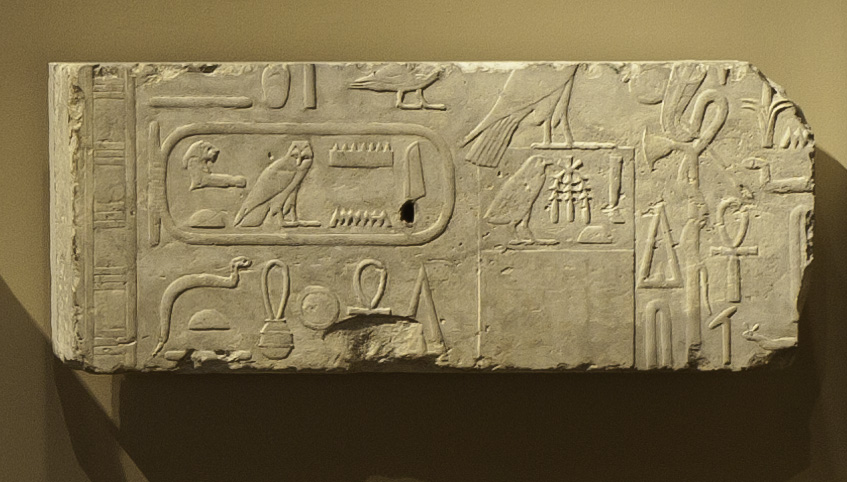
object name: relief, senwosret i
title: Relief block with the names and titles of Amenemhat I and Senwosret I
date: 1962-1952 BCE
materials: limestone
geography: egypt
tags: cartouches,hieroglyphs